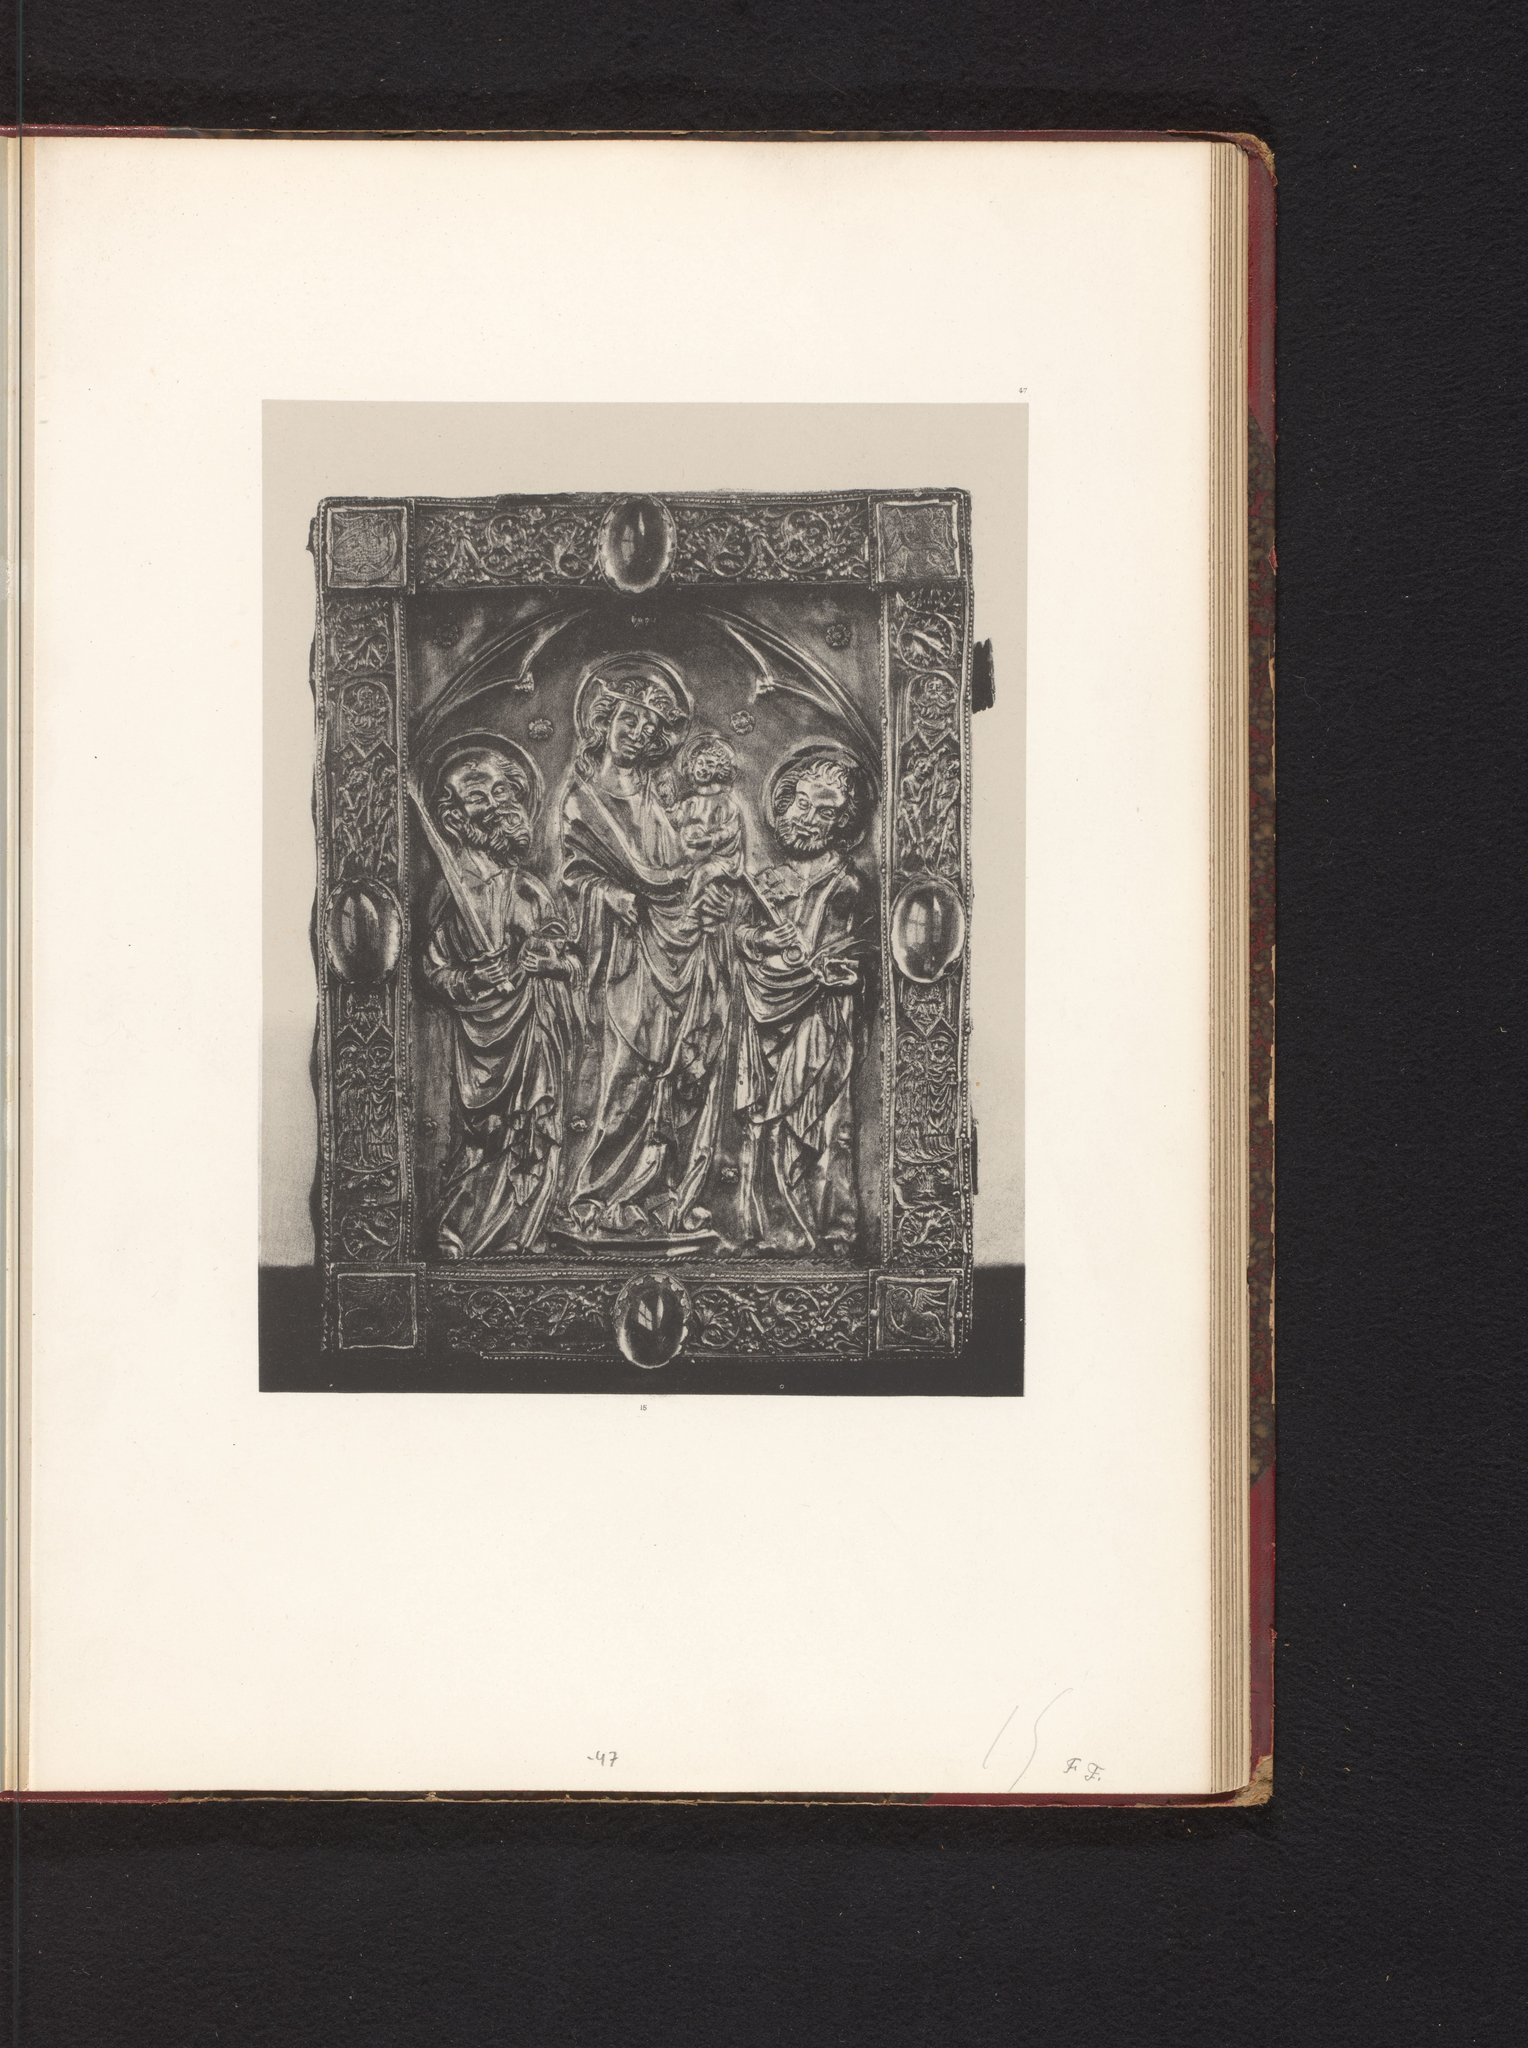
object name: photomechanical print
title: Boekband met Maria en kind en Pieter en Paulus uit de Onze-Lieve-Vrouwebasiliek in Tongeren, opgesteld op een tentoonstelling over religieuze objecten uit de middeleeuwen en renaissance in 1864 in Mechelen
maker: joseph maes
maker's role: fotograaf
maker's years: 1838-1908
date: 1864-1866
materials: paper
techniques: photolithography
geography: antwerp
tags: mary standing (or half-length), the christ-child sitting on her arm (christ-child to mary's left), book-cover, binding, mechelen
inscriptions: number: ‘15’, number: ‘15 F.F.’, number: ‘-47’